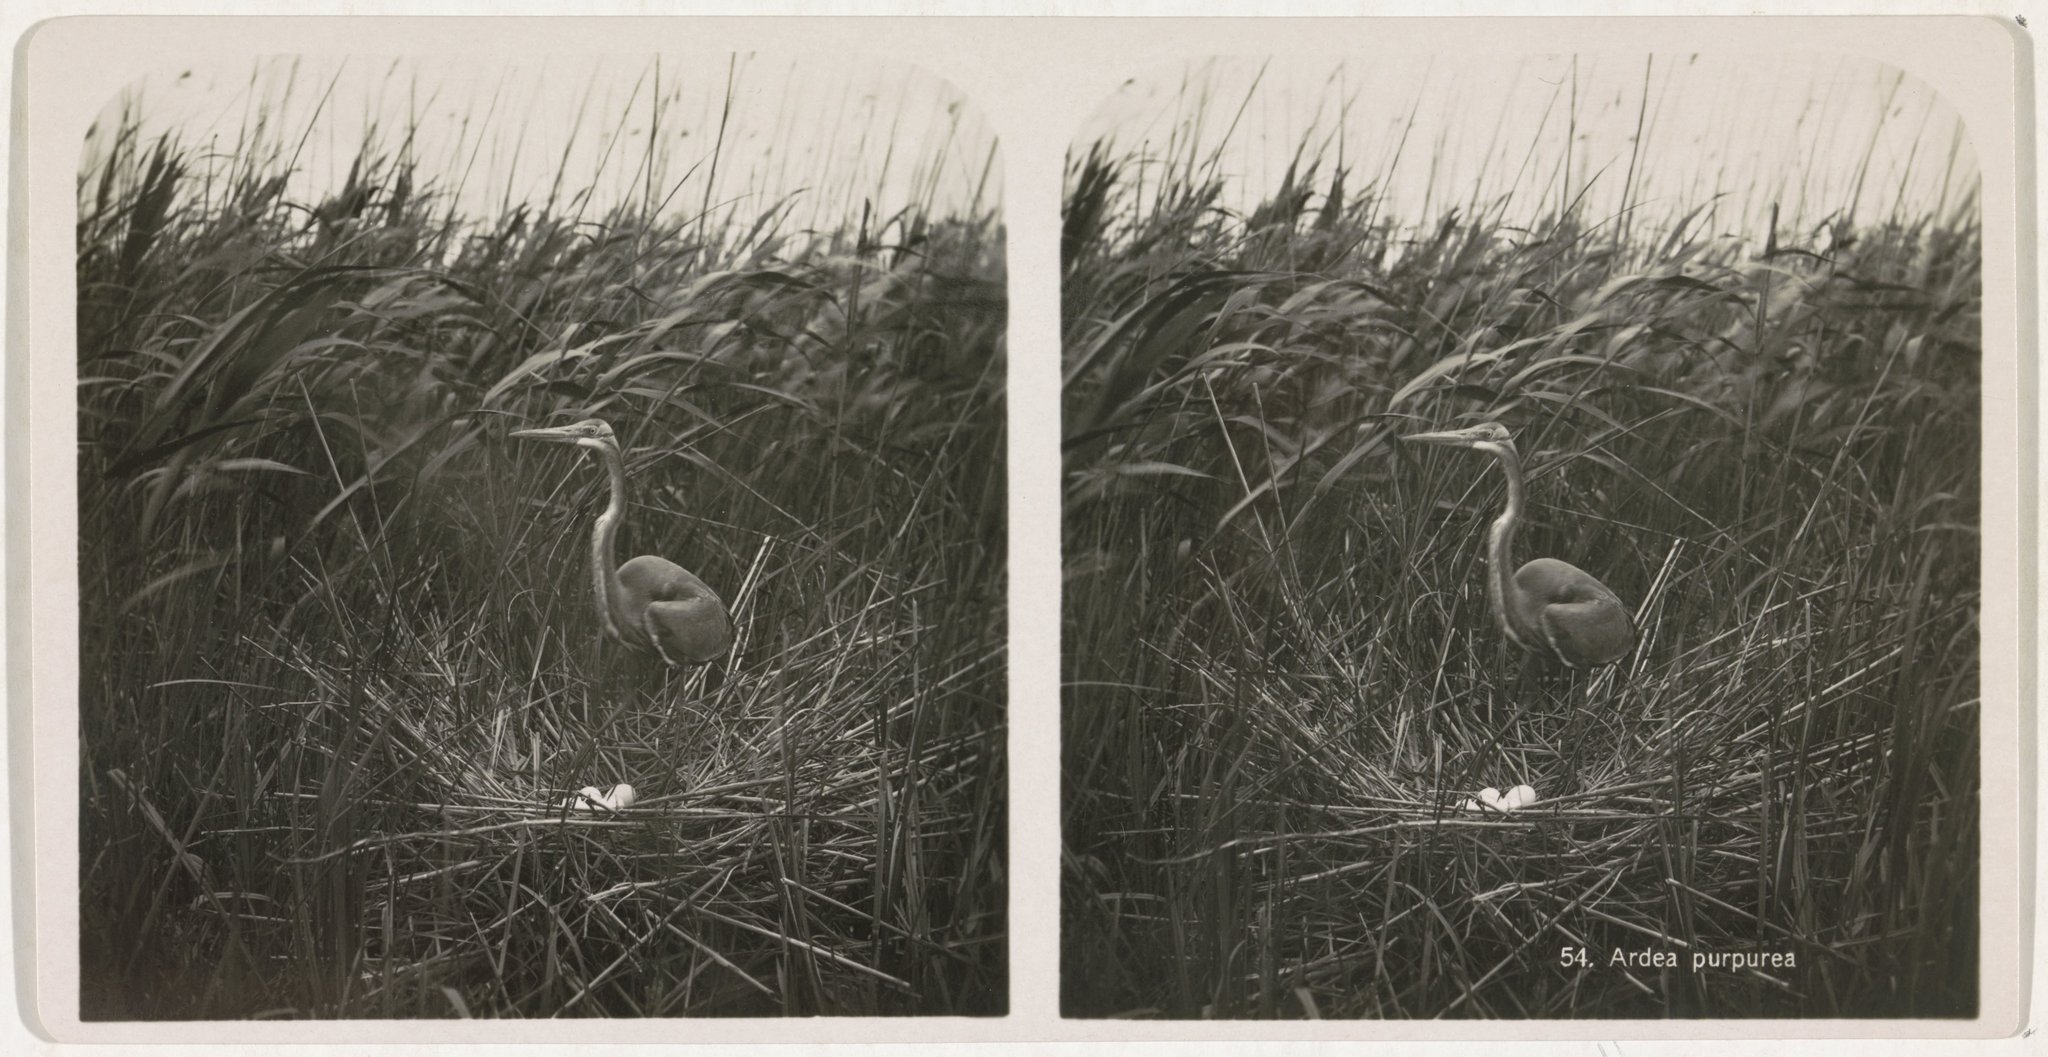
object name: photograph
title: Onze vogels in 't wild. / Moerasvogels / Lepelaar, Reiger, Roerdomp, Dodaars, Zwarte Stern.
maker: adolphe burdet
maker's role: fotograaf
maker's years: 1860-1940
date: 1870-1940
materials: photographic support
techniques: gelatin silver print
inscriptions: label: ‘Reiger’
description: De foto is afkomstig uit een serie van 12 stereofoto's met moerasvogels die bewaard worden in het originele mapje. Bij dit mapje zit ook een blaadje met gedrukte tekst over de vogels.